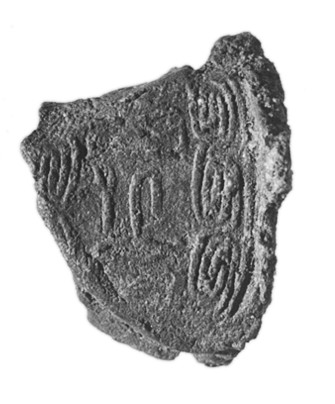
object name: sealing fragment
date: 2030-1640 BCE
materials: clay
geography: egypt